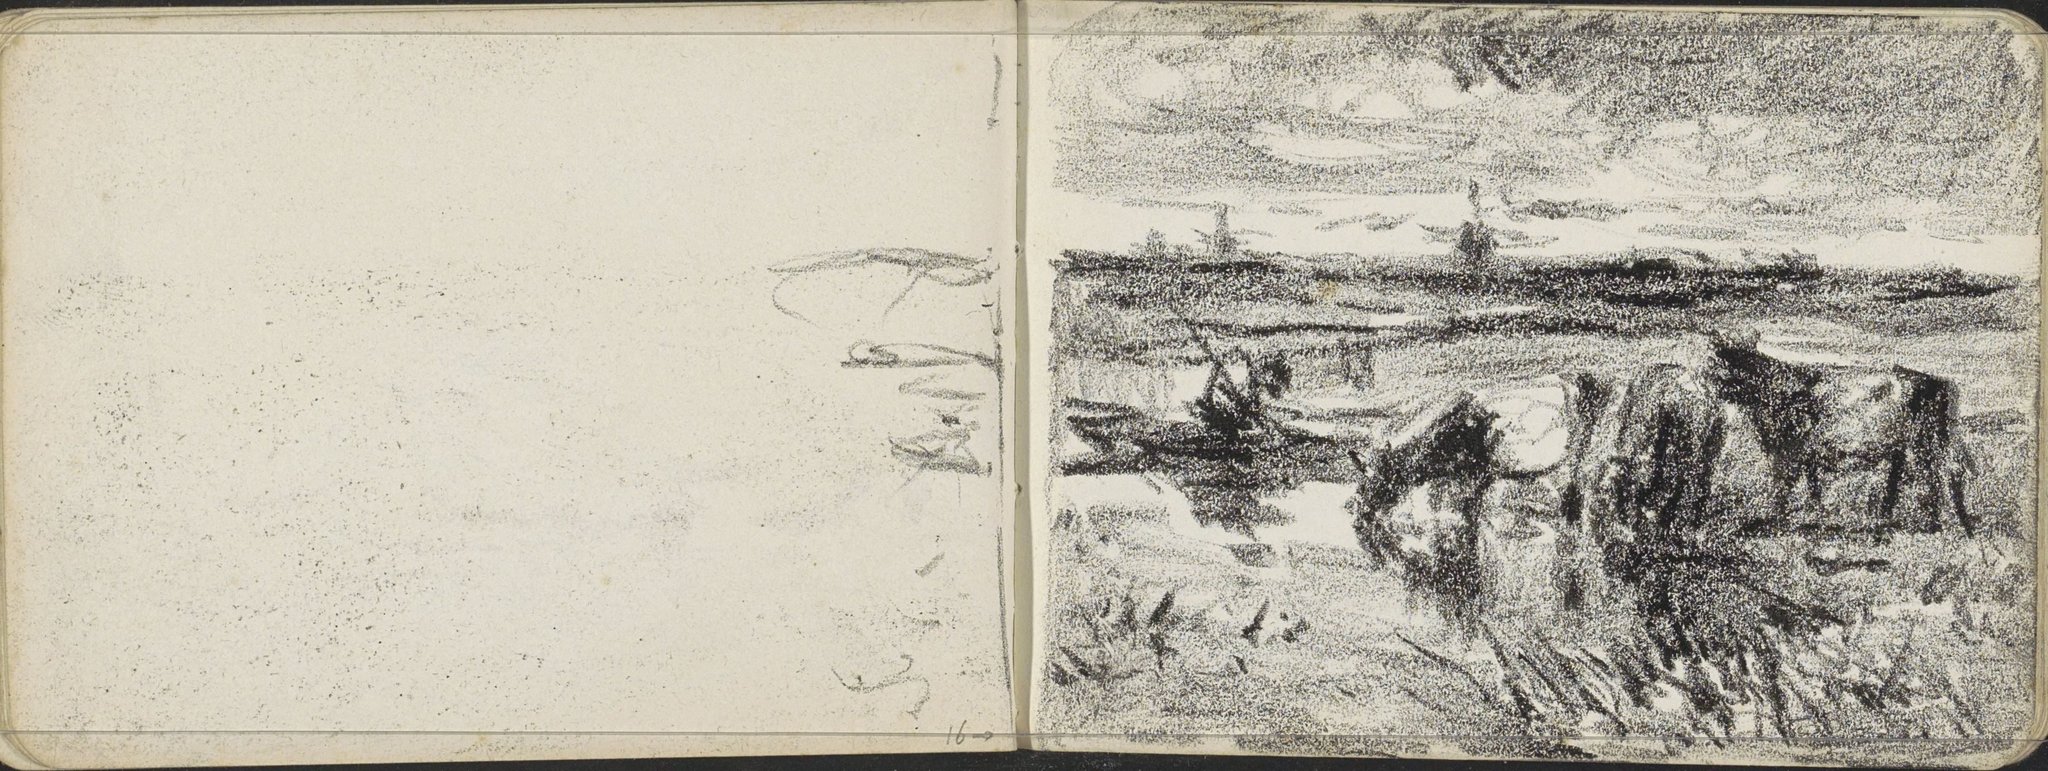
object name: sketchbook leaf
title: Weiland met koeien aan een waterkant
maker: willem cornelis rip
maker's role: draughtsman, painter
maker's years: 1856-1922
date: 1907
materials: chalk, paper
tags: cattle, landscapes with waters, waterscapes, seascapes (in the temperate zone)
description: Aan de waterkant staat een man in een roeiboot. Blad 15 verso en 16 recto uit een schetsboek met 41 bladen.